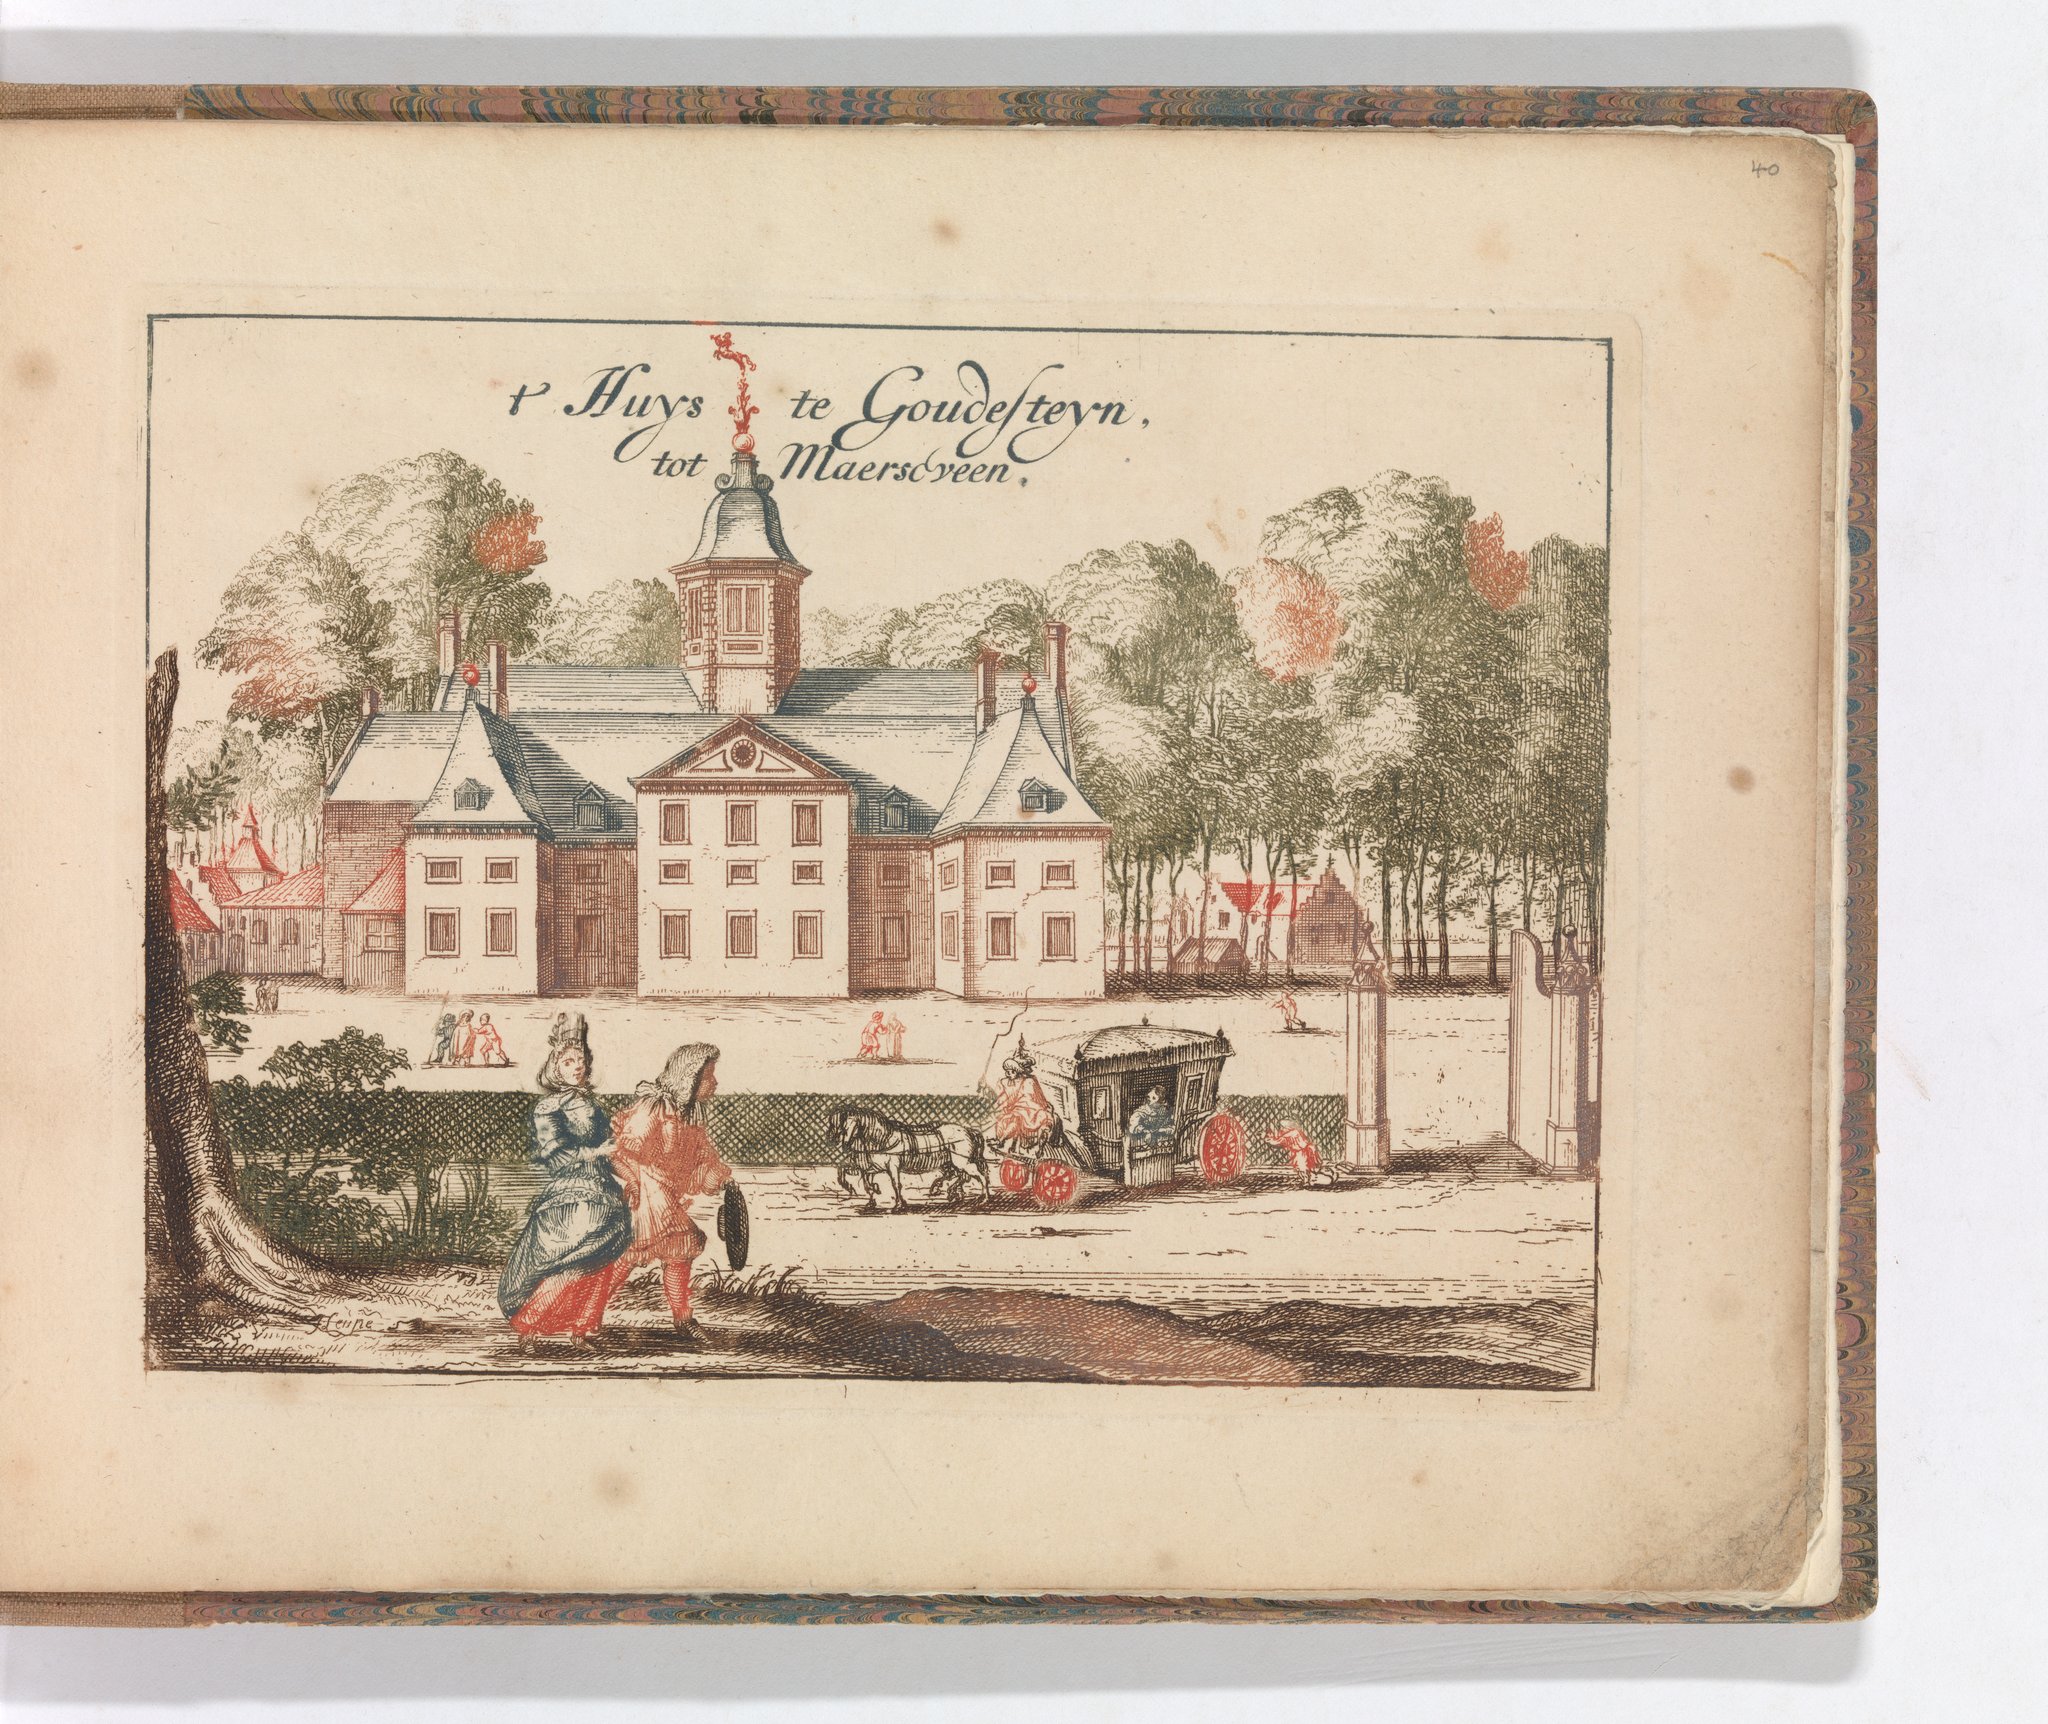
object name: book print ornament architecture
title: ' 't Huys te Goudesteyn tot Maerseveen' in: Tooneel Der Voornaamste Nederlands Huizen, En Lust Hoven, Naar T Leven Afgebeeld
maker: carel allard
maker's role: publisher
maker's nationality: dutch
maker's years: 1648-1709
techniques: engraving, lithography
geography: amsterdam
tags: palaces,men,women,horses,carriages